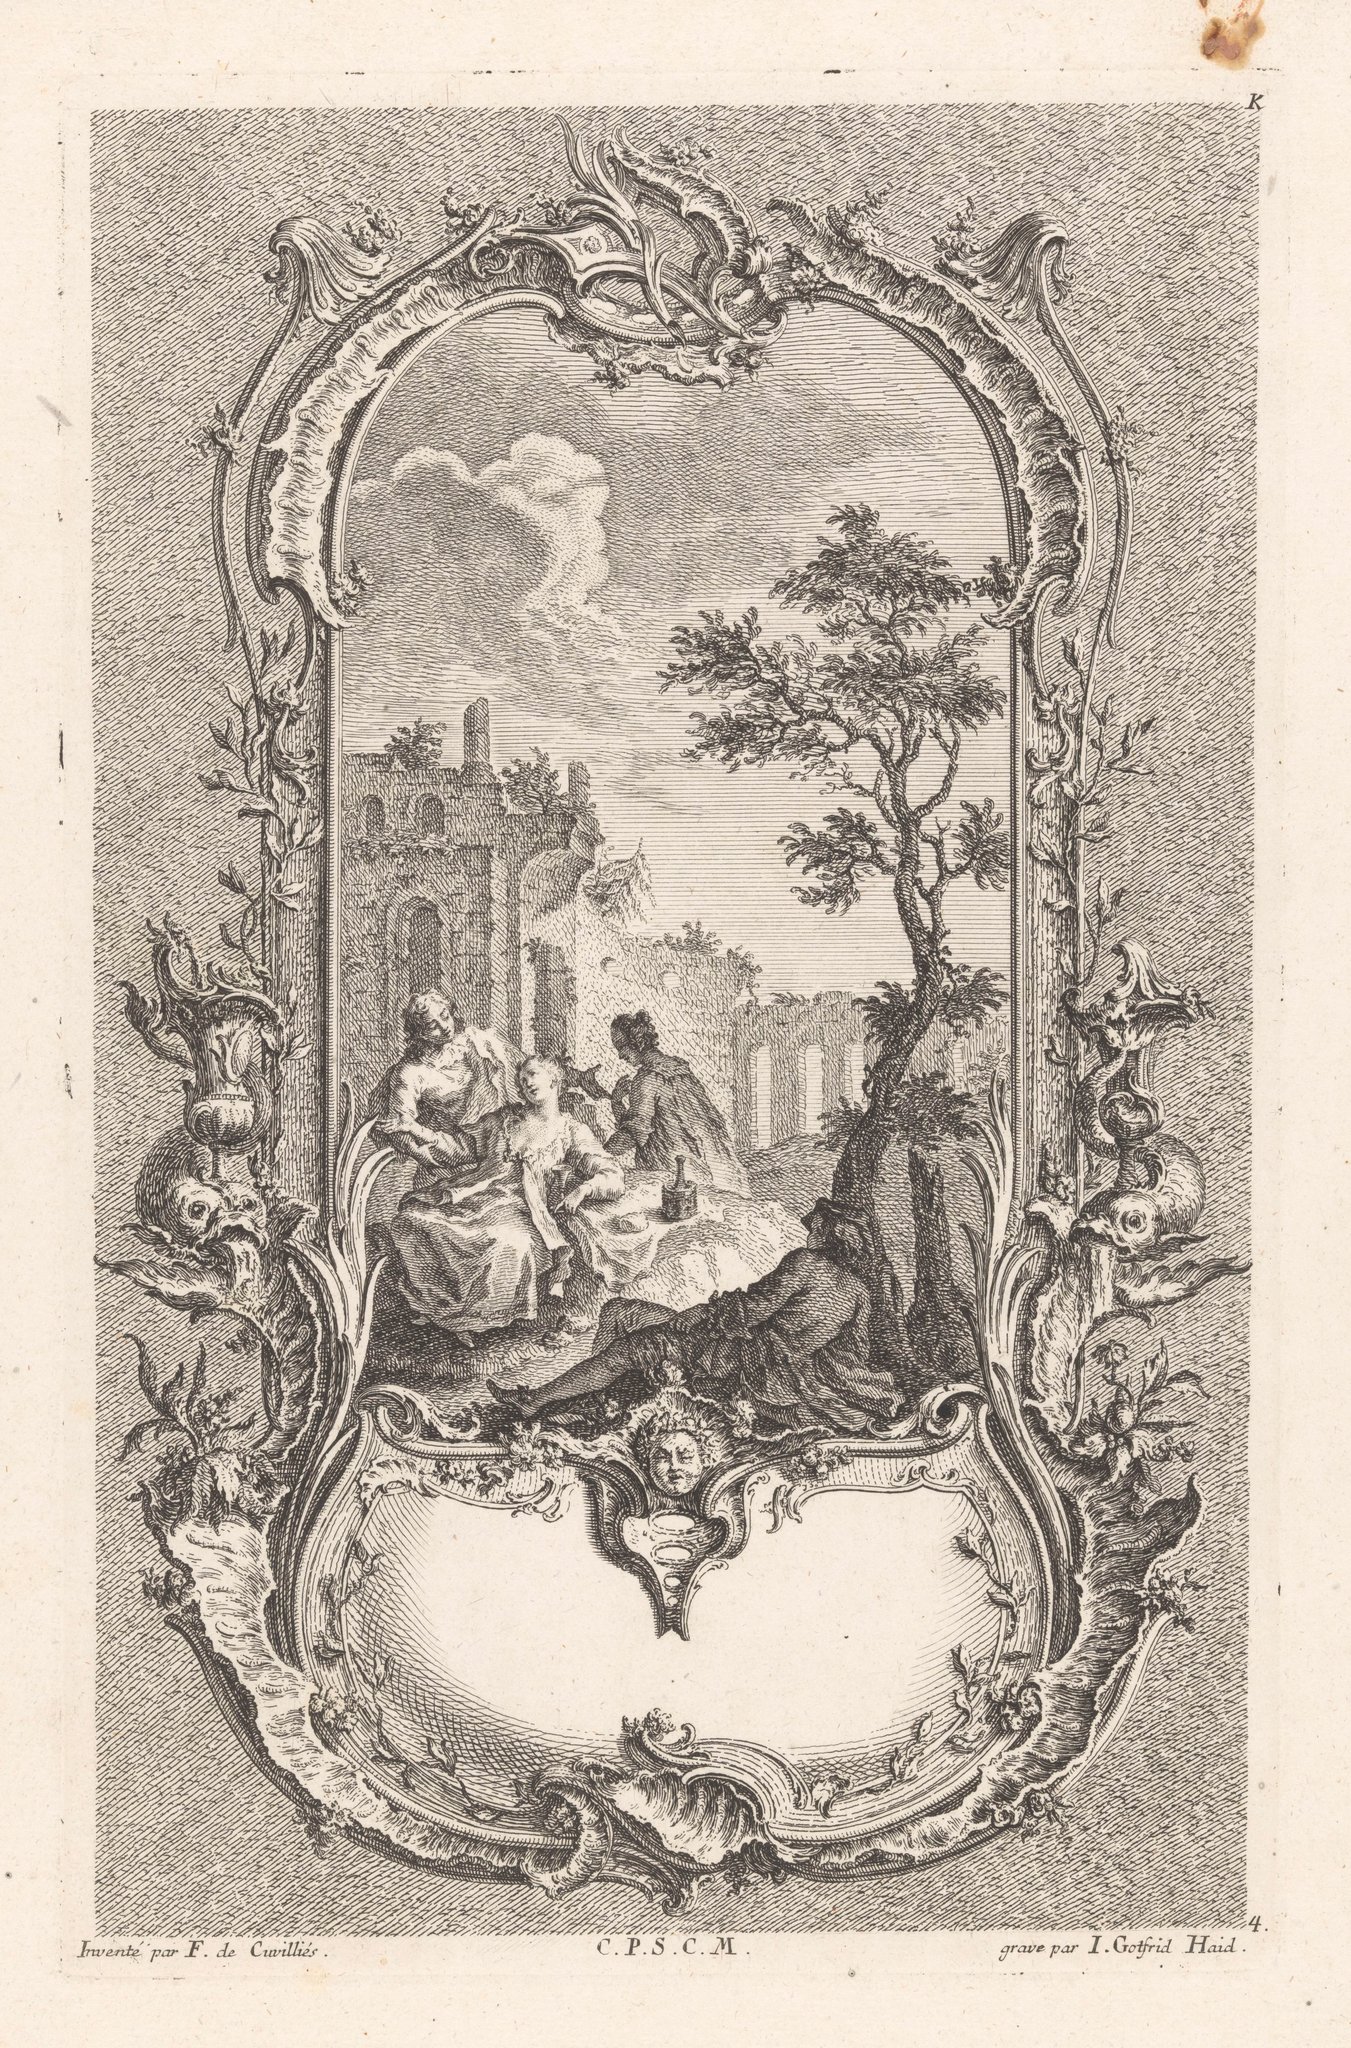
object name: ornament print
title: 10me Livre K Morceaux De Caprices, A Divers Usages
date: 1745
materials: paper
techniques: engraving, etching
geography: paris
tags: sitting figure, landscape with ruins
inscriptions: collector's mark: Lugt 2228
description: Twee zittende vrouwen en een jongeman zitten in een ruïnelandschap. Een liggende figuur op de rug gezien kijkt naar het trio. Rondom de voorstelling een geornamenteerde omlijsting.